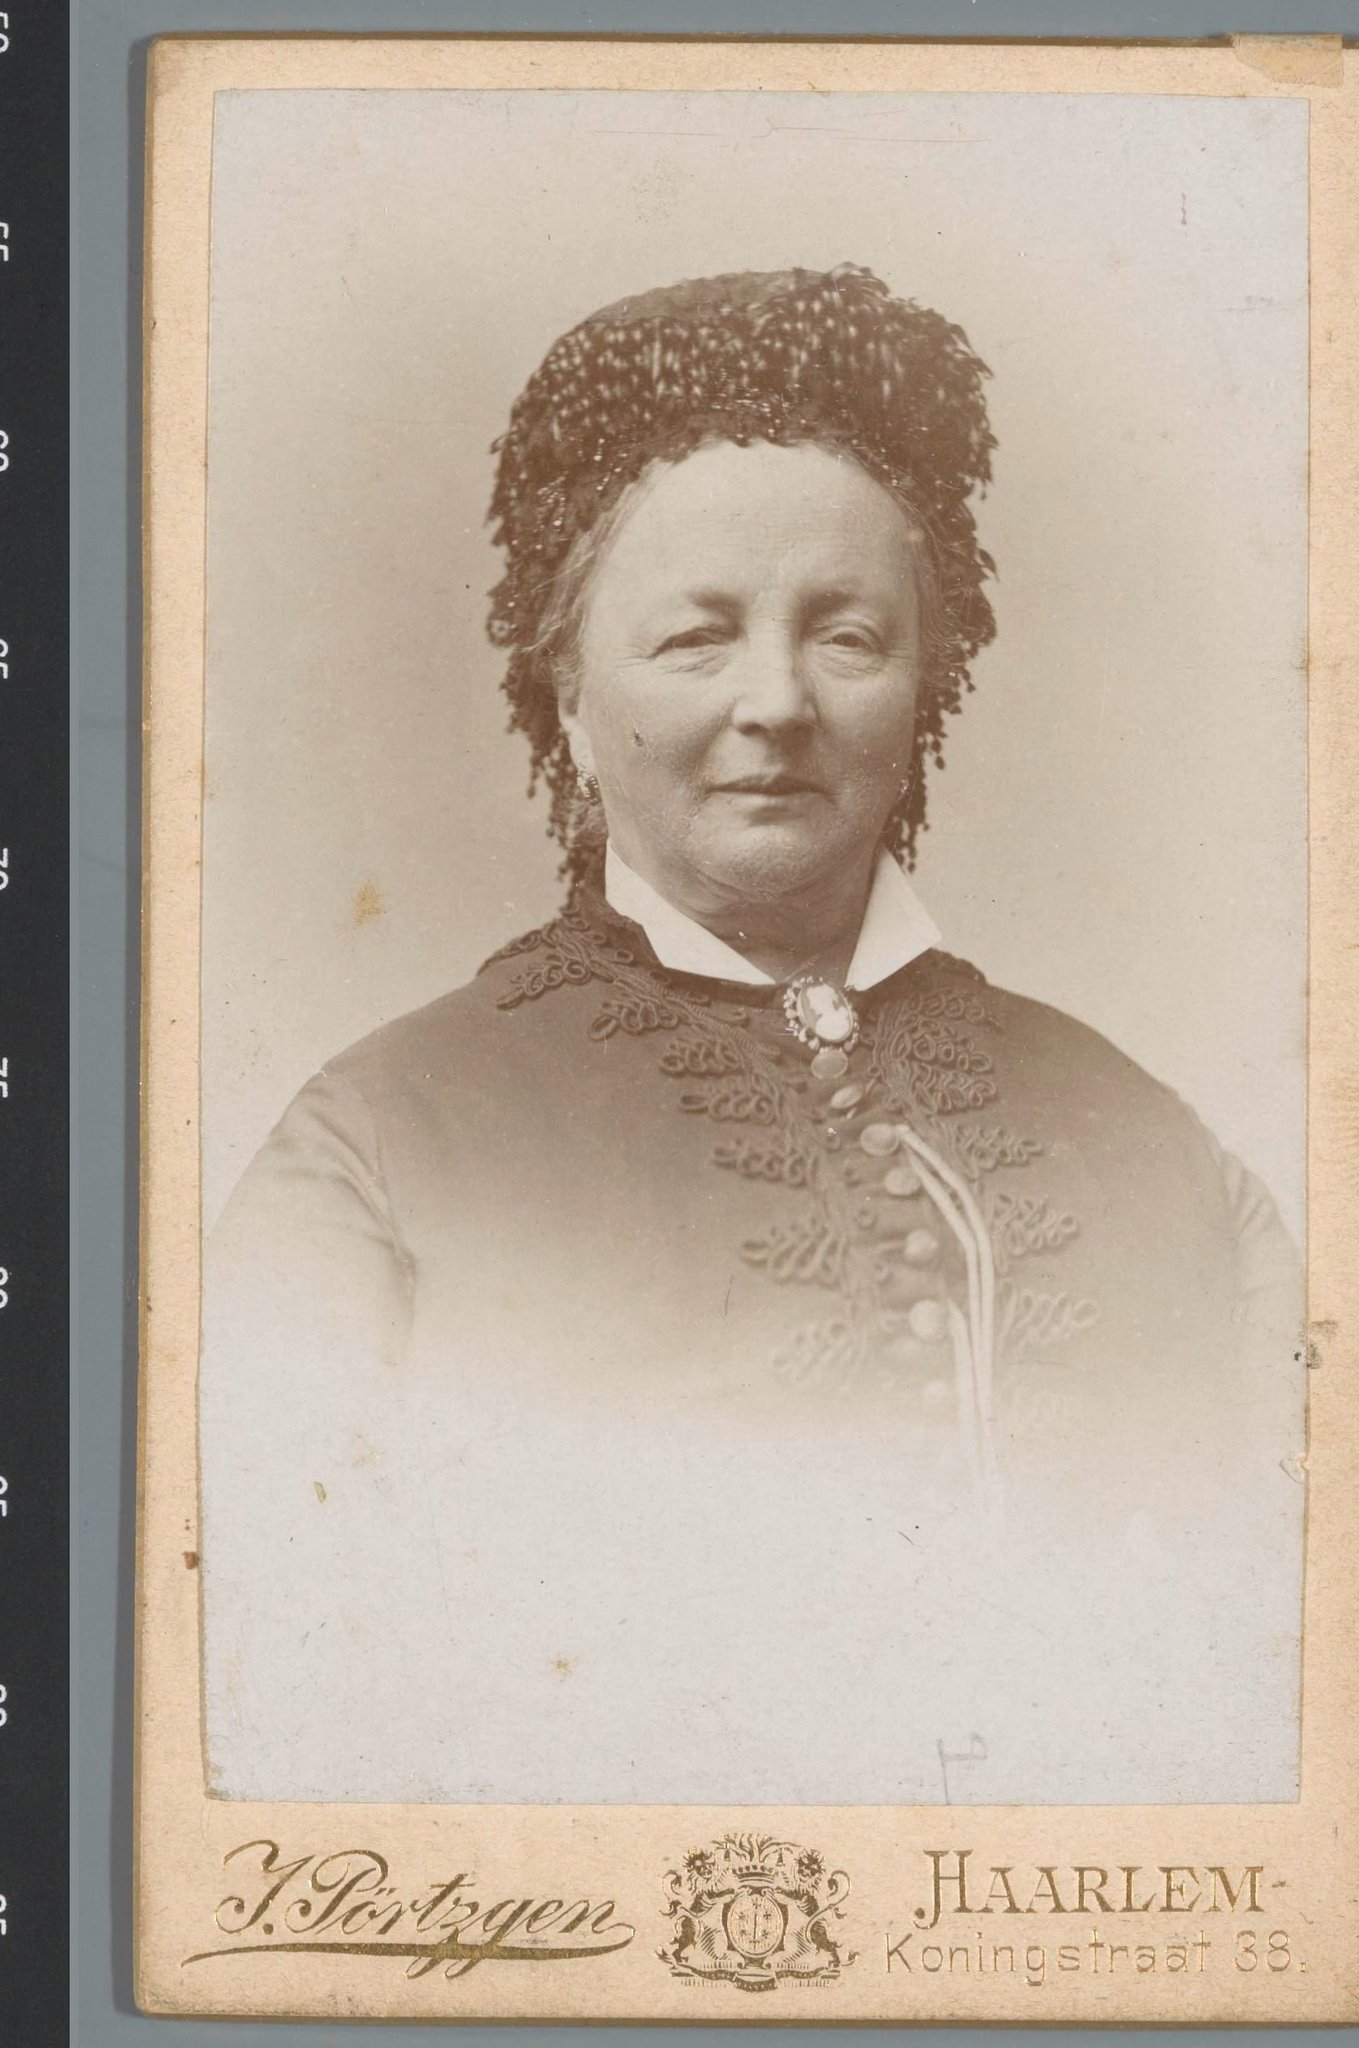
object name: carte de visite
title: Portret van een onbekende vrouw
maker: johann pörtzgen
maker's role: fotograaf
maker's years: 1857-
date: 1882-1900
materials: cardboard, photographic support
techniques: collodion silver print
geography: haarlem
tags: historical persons - bb - woman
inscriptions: inscription: ‘J. Pörtzgen/ HAARLEM/ Koningstraat 38./ De platen blijven bewaard./ TRAPP & MÜNCH, BERLIN. W.’